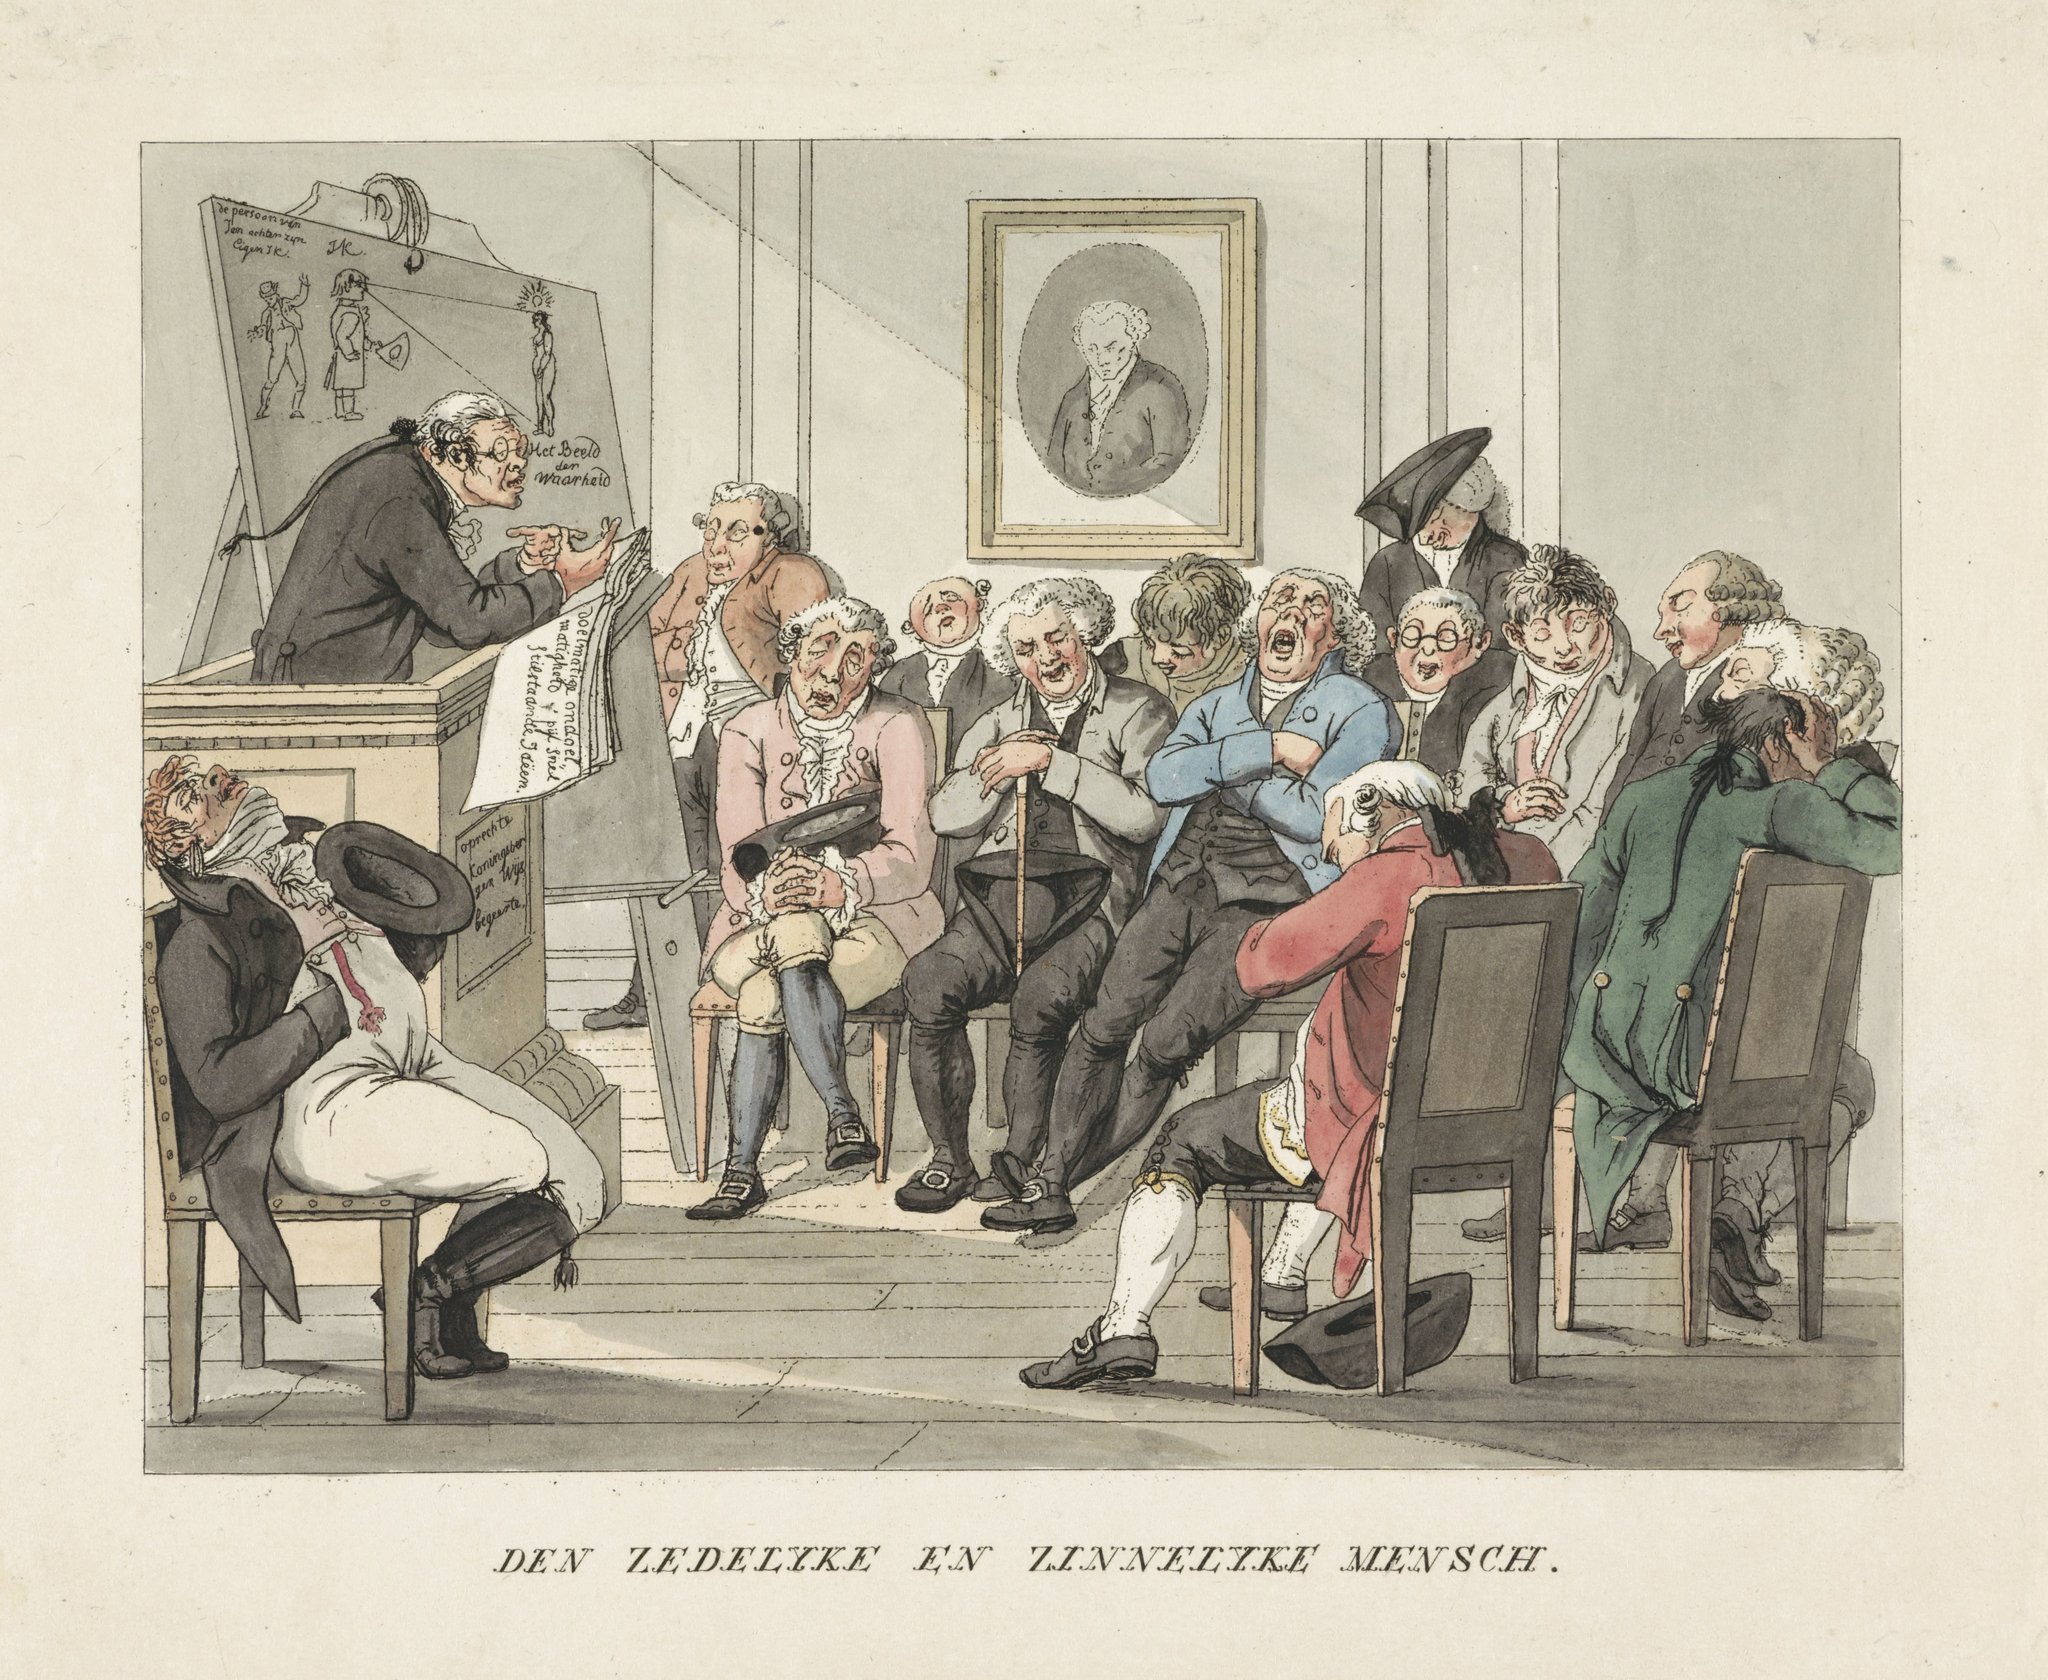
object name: print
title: Karikaturen van de maatschappij rond 1800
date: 1800-1805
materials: paper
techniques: etching, hand coloring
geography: netherlands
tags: address, talk, lecture (~ meeting), sleeping in chair, caricatures (human types), philosophy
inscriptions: collector's mark: Lugt 2228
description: Een wijsgeer houdt een redevoering over de Kantiaanse wijsbegeerte voor een slapend publiek. Onderdeel van een reeks van die karikaturale platen over de maatschappij rond 1800.